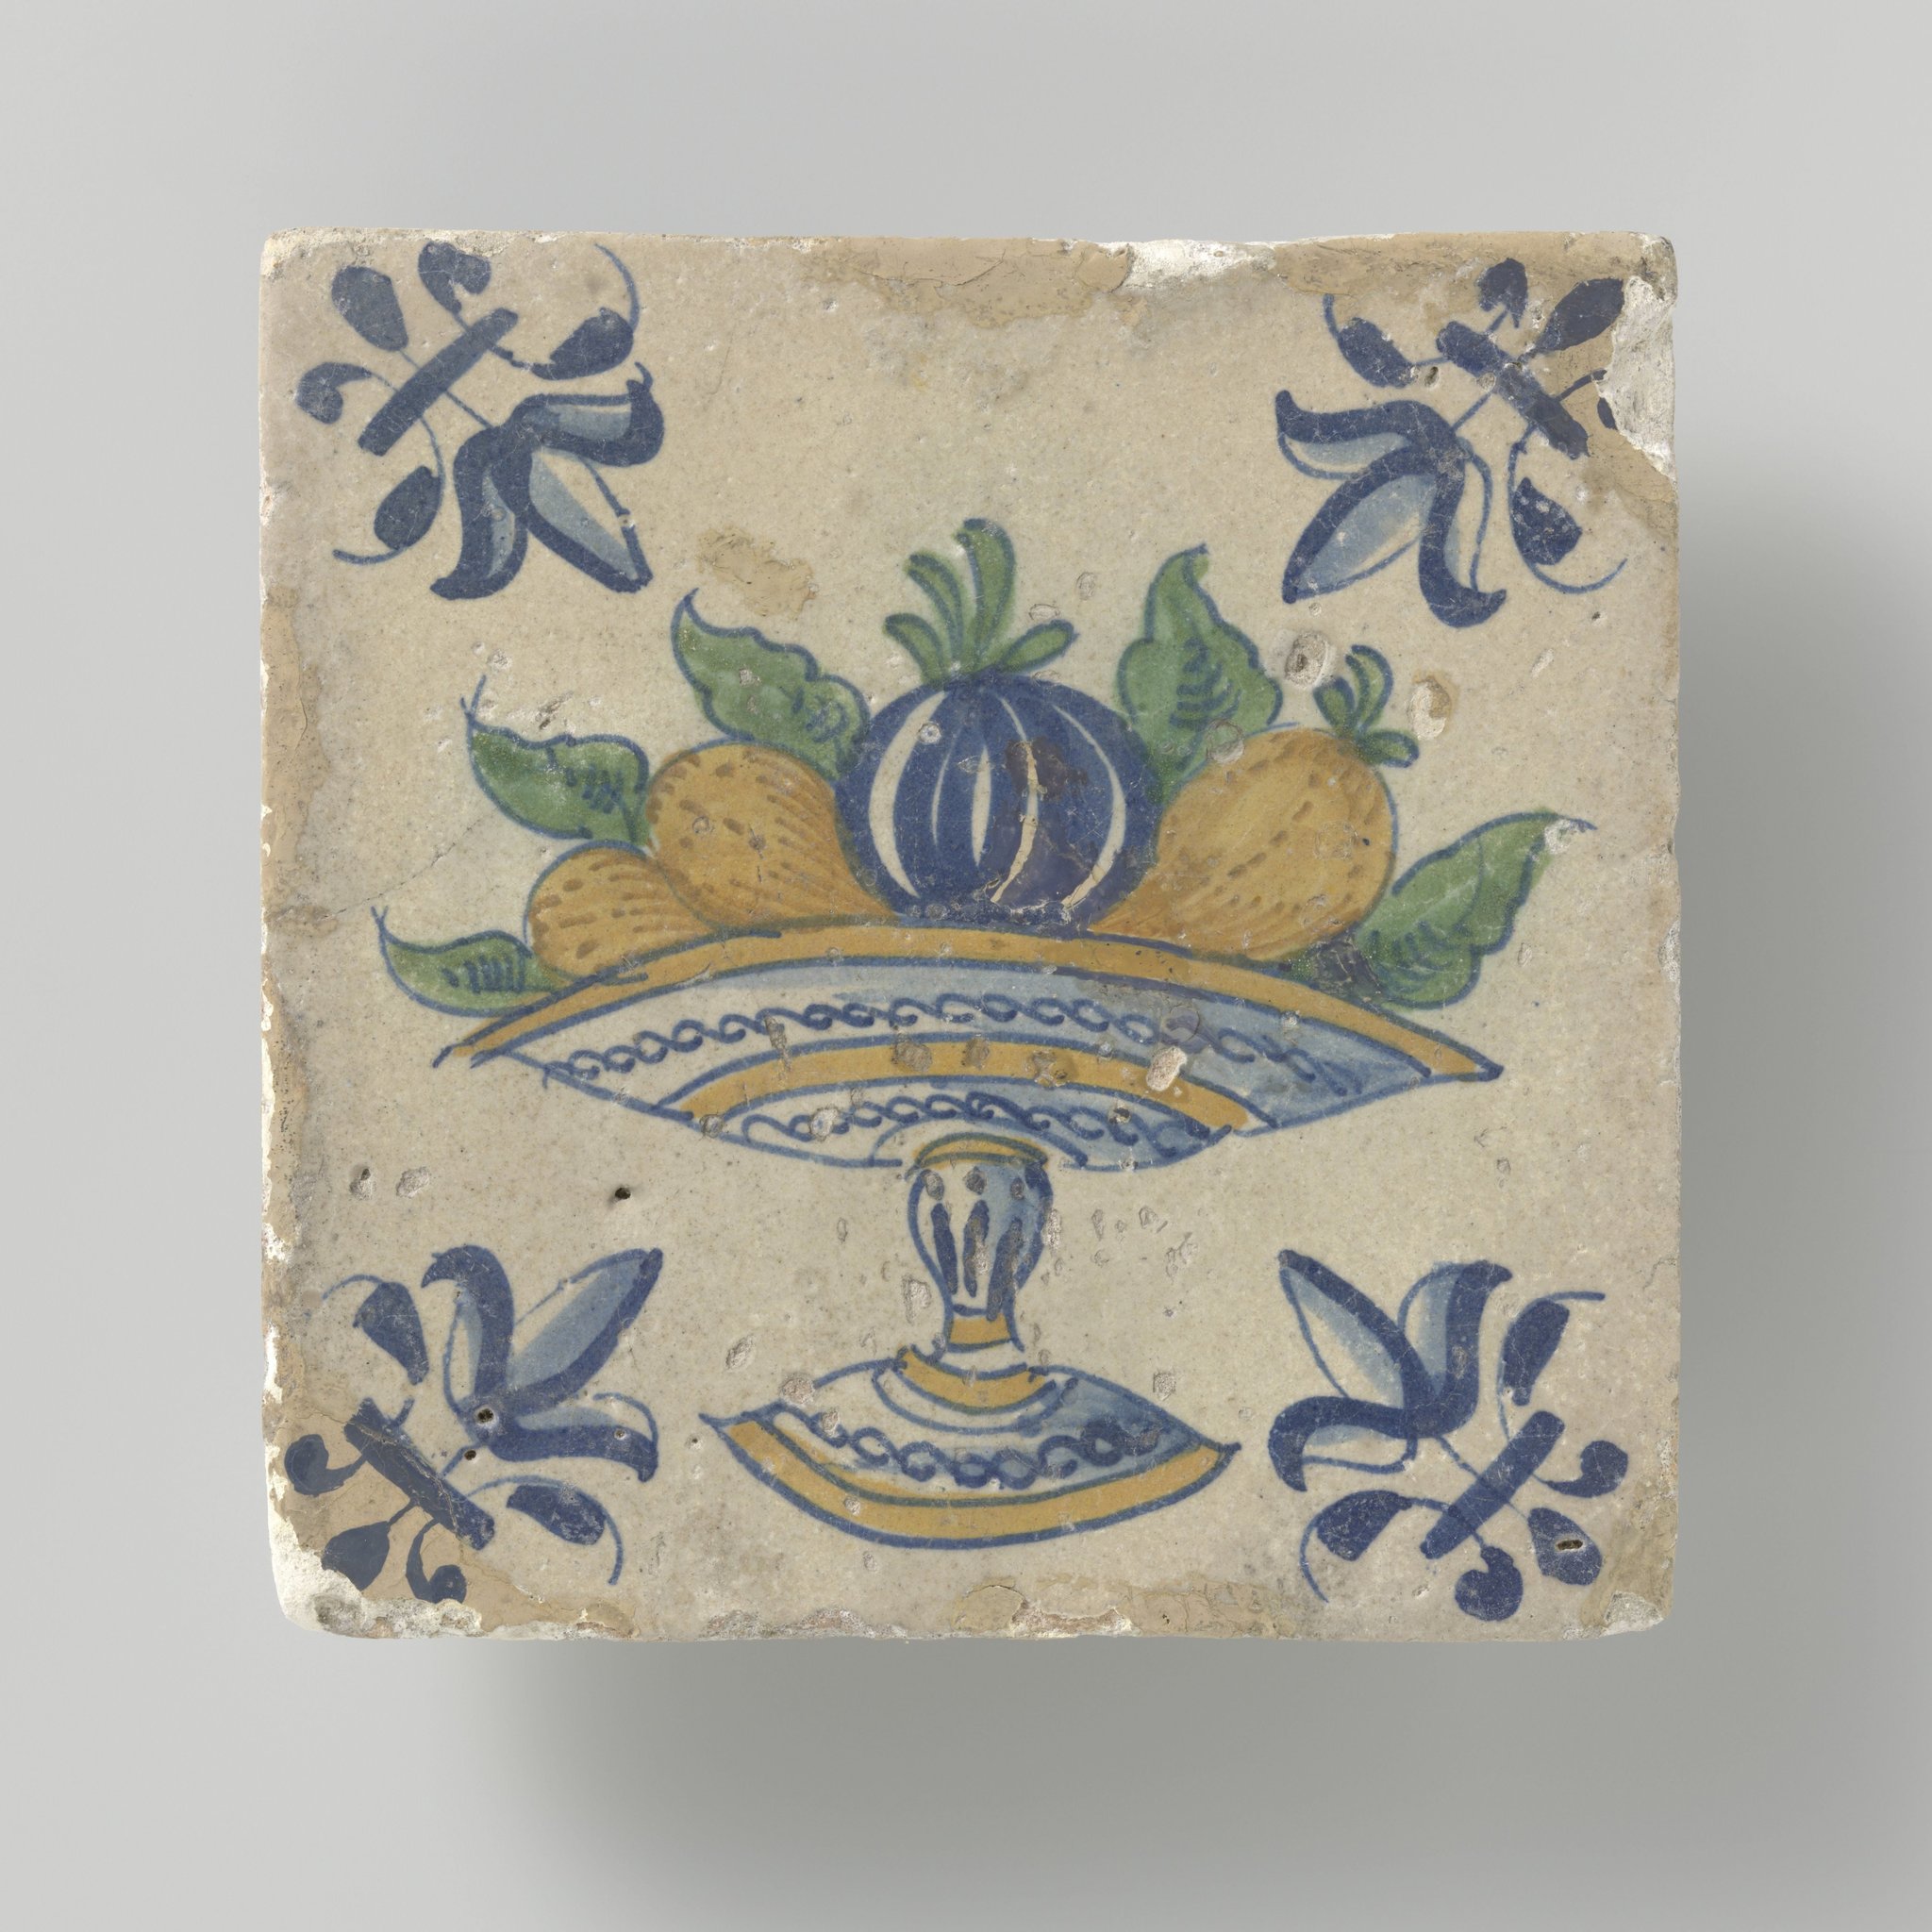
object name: tile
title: Tegel met fruitschaal op voet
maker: Anonymous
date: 1640-1660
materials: earthenware, glaze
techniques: maiolica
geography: netherlands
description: Tegel met een veelkleurige (blauw, groen, geel en oranje) fruitschaal op voet en in de hoeken een lelie.